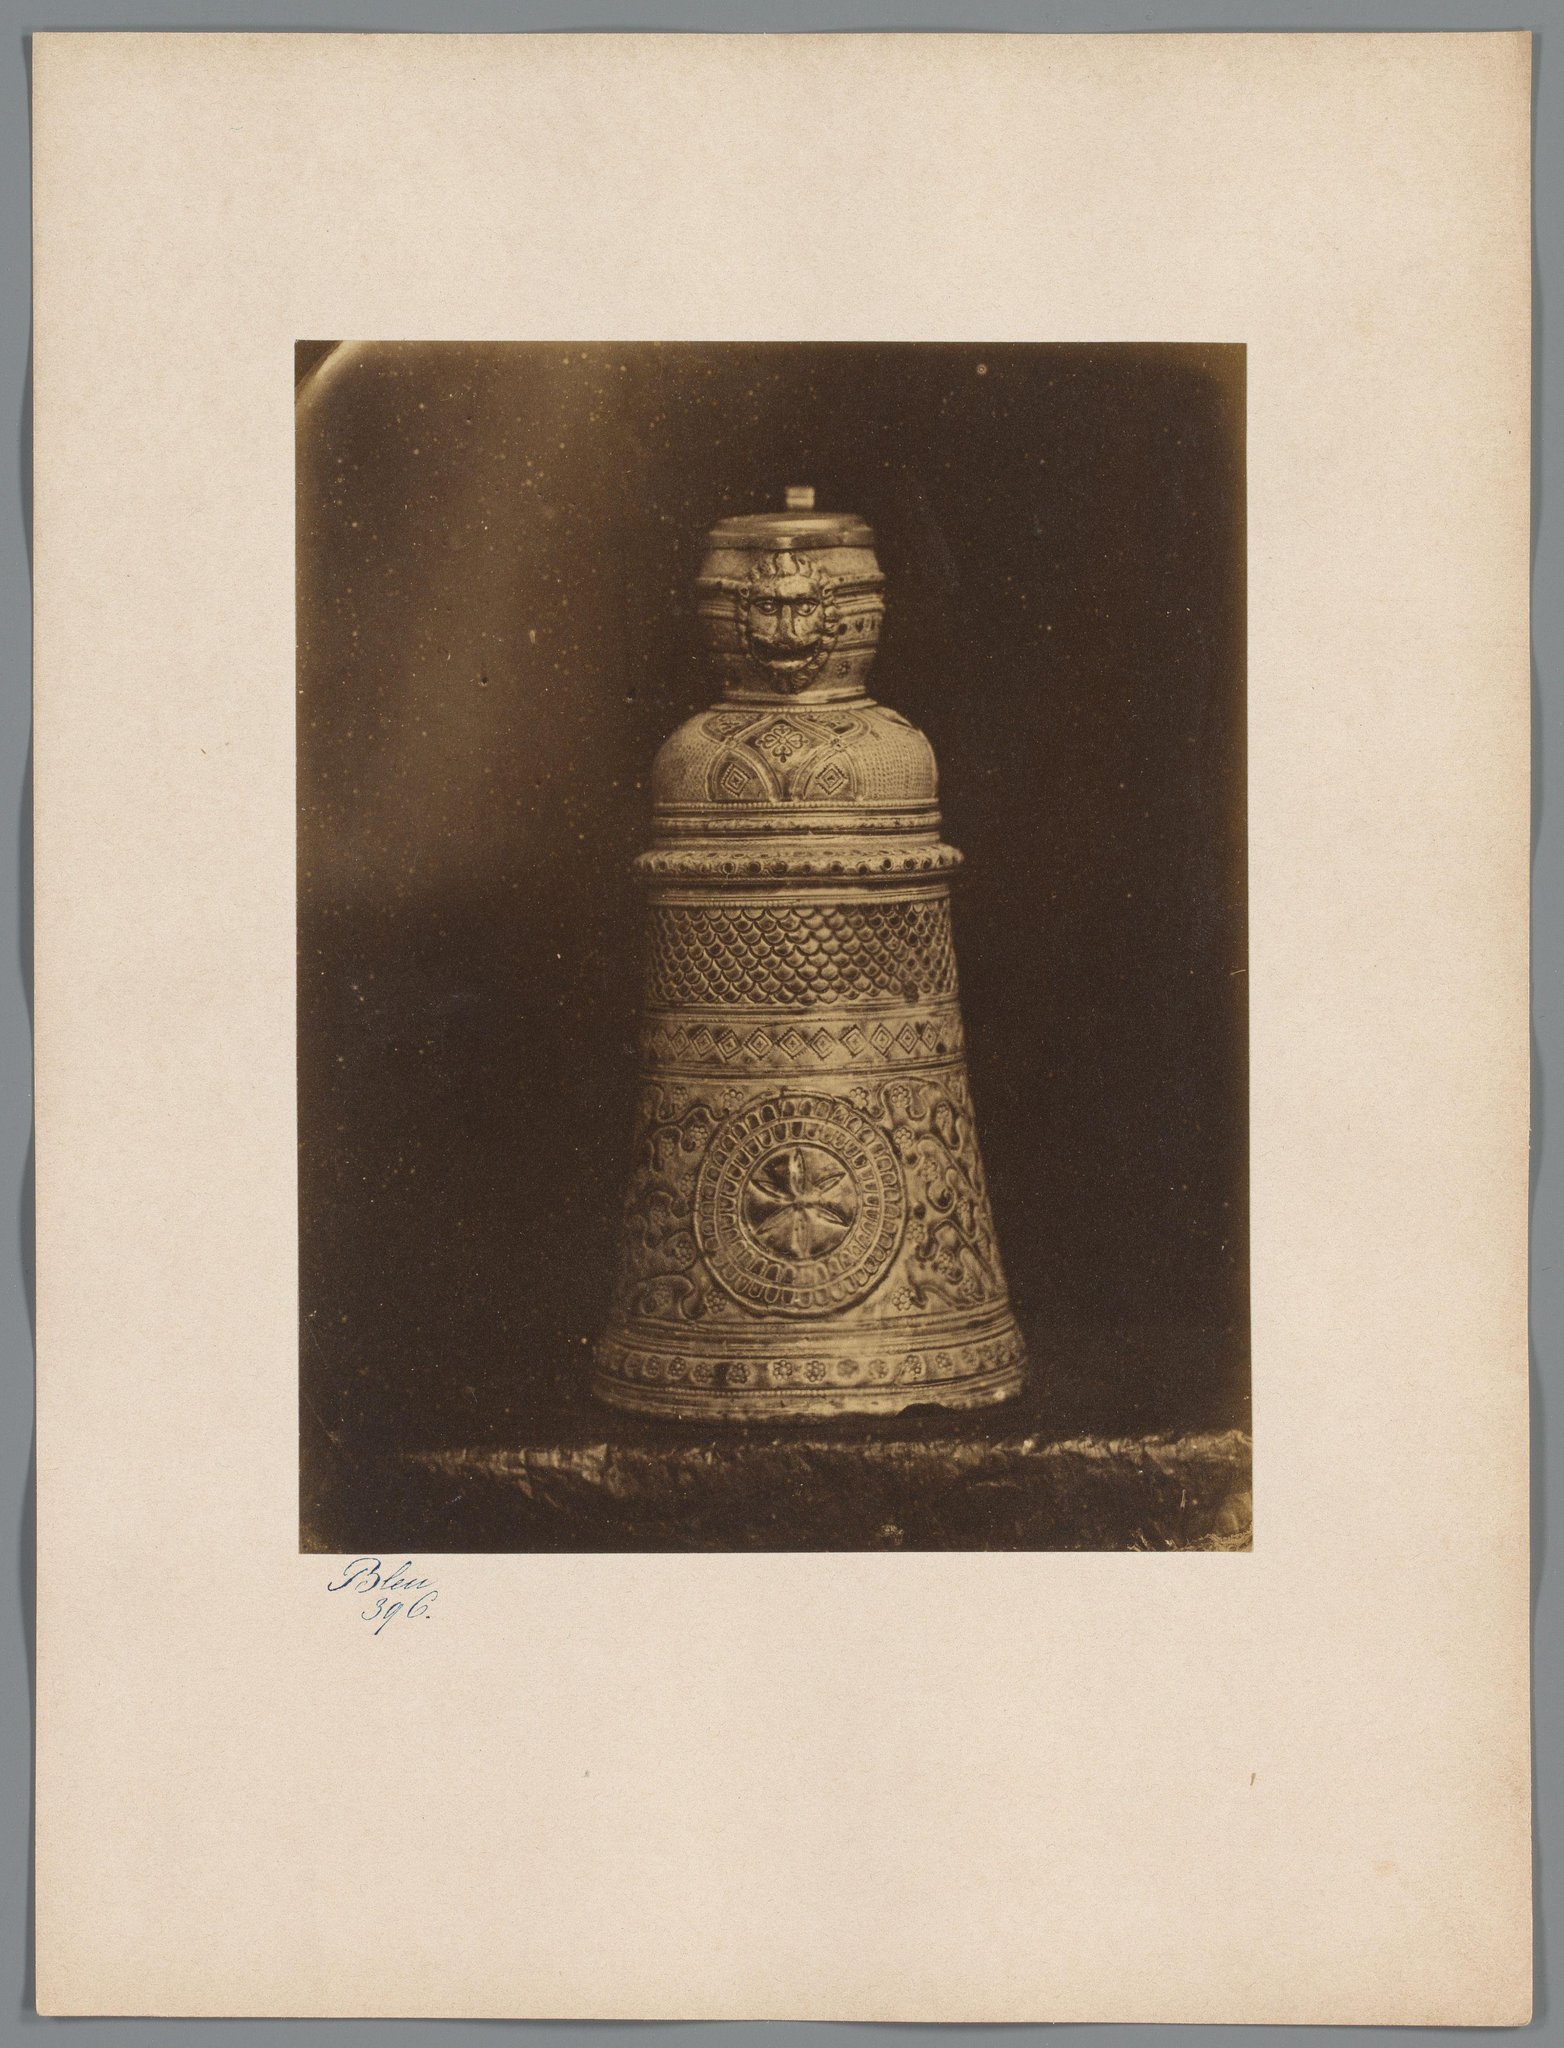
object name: photograph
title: Aardewerken vaas uit de collectie van W. de Weckherlin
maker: Anonymous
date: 1860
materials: paper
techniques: albumen print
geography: the hague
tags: container of ceramics: jar, jug, pot, vase, the hague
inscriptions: inscription: ‘Bleu/ 39G.’